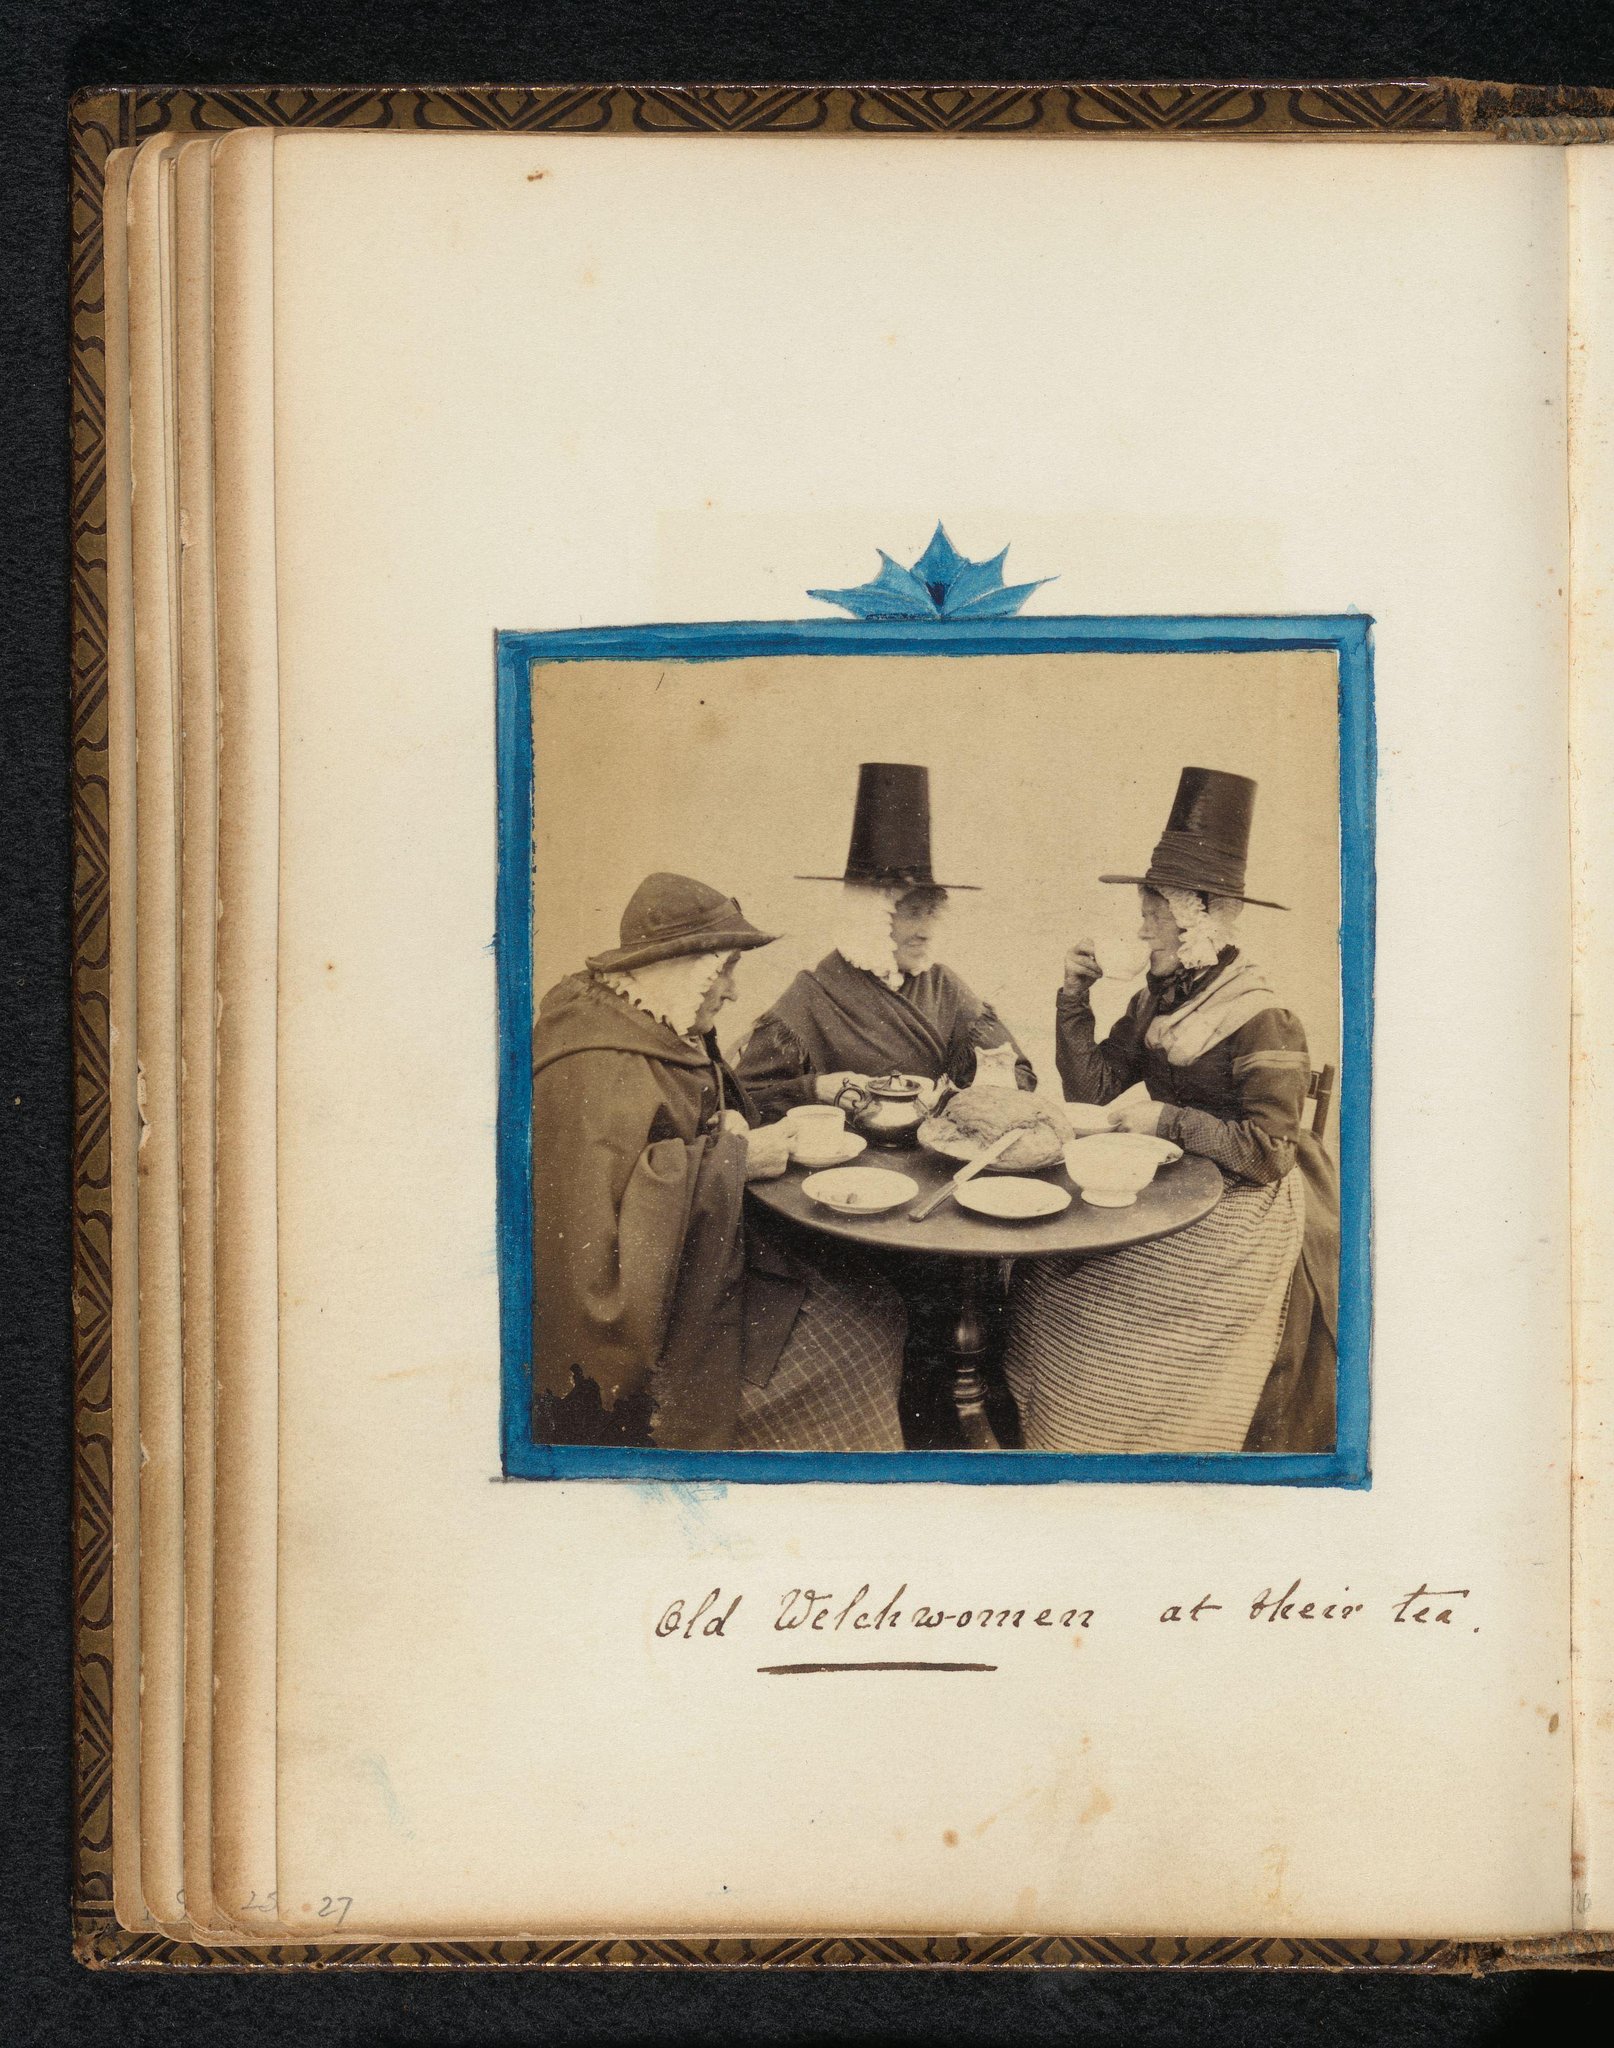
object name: photograph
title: Old Welchwomen at their tea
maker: Anonymous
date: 1865-1867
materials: cardboard, photographic support, watercolor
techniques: albumen print, aquarelle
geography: england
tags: folk costume, regional costume, afternoon tea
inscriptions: annotation: ‘Old Welchwomen at their tea’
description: Drie vrouwen uit Wales in klederdracht, aan de thee. Foto op albumblad in album met 68 foto's merendeels met geaquarelleerde randversieringen. Het zijn voornamelijk portretten op carte-de-visite formaat.